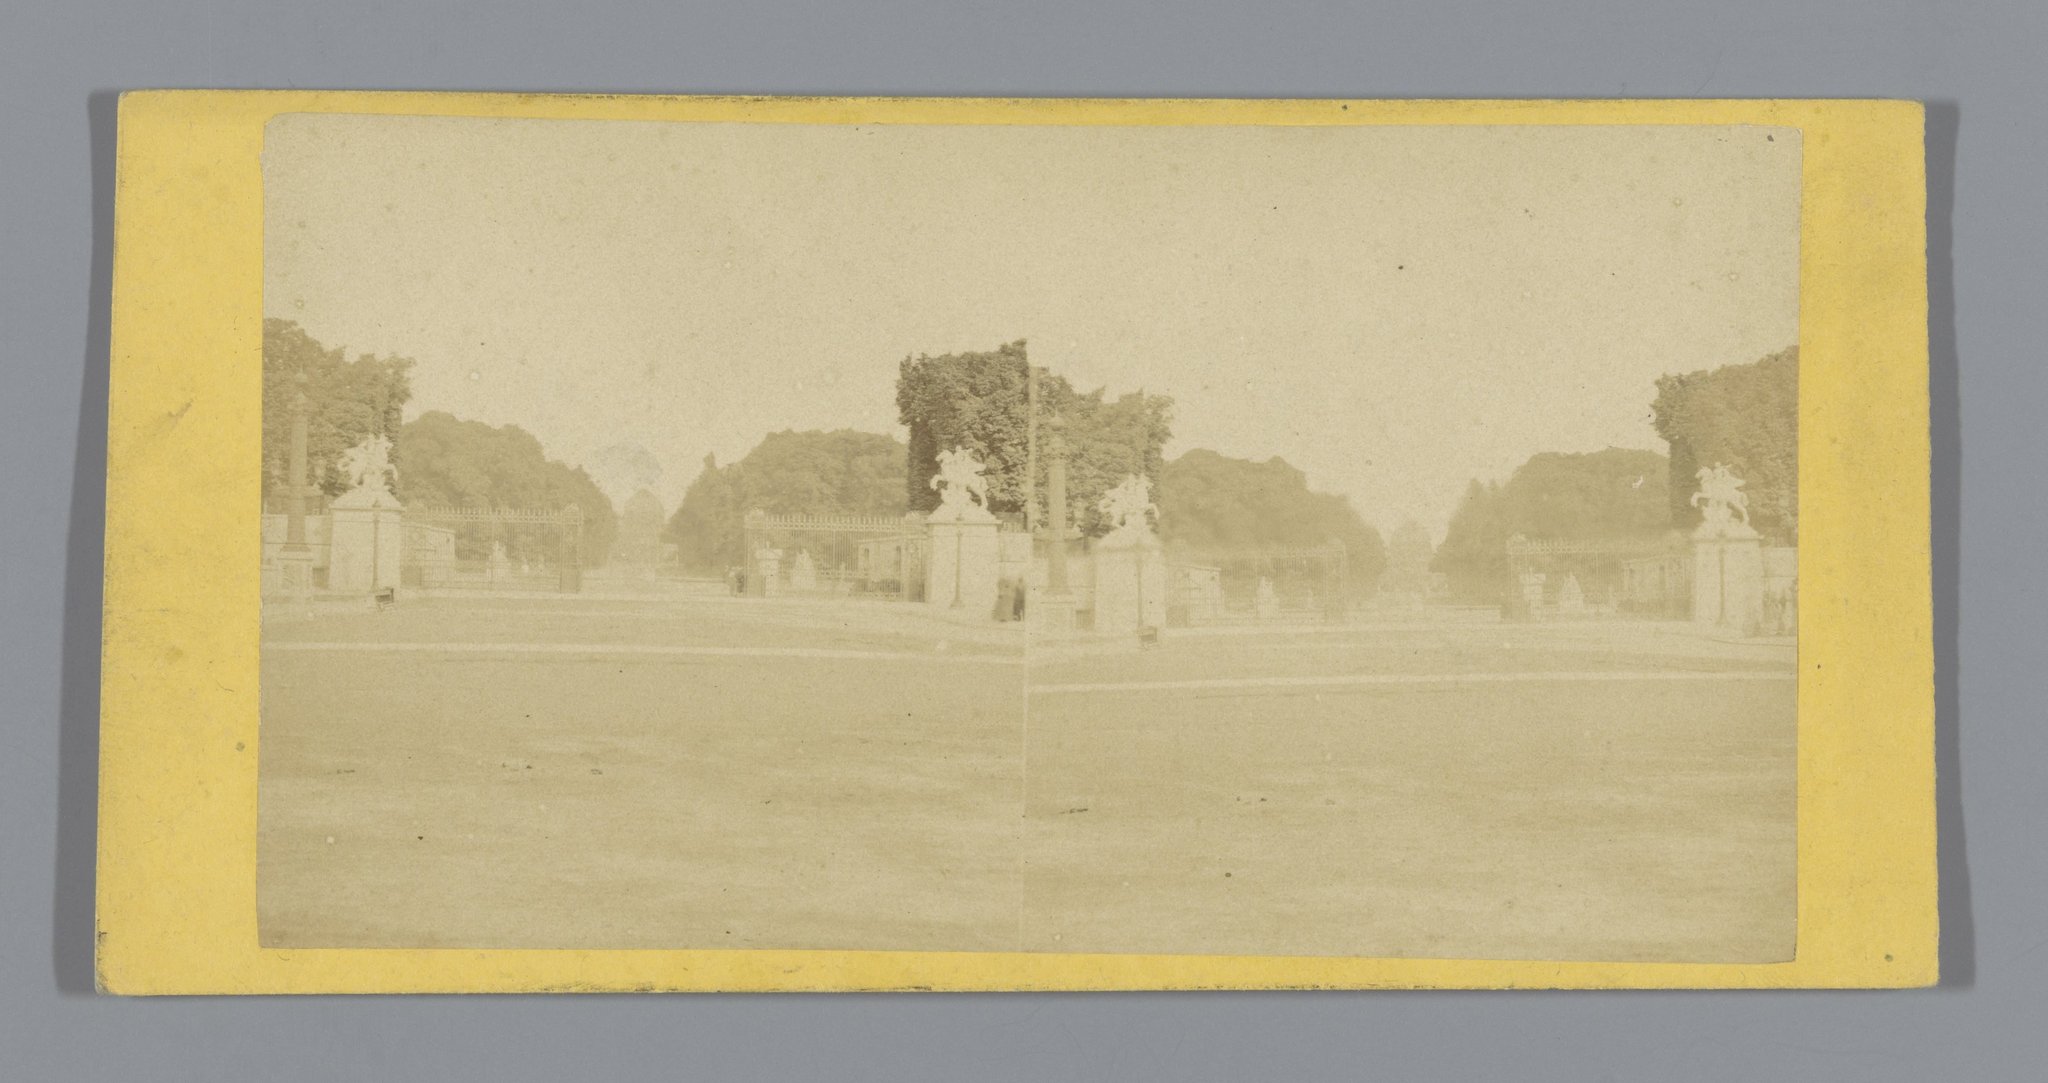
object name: stereograph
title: Gezicht op de Tuilerieën te Parijs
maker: Anonymous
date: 1850-1875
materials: cardboard, photographic support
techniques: albumen print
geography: jardin des tuileries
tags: french or architectonic garden; formal garden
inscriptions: inscription: ‘Jardin des Tuileries’